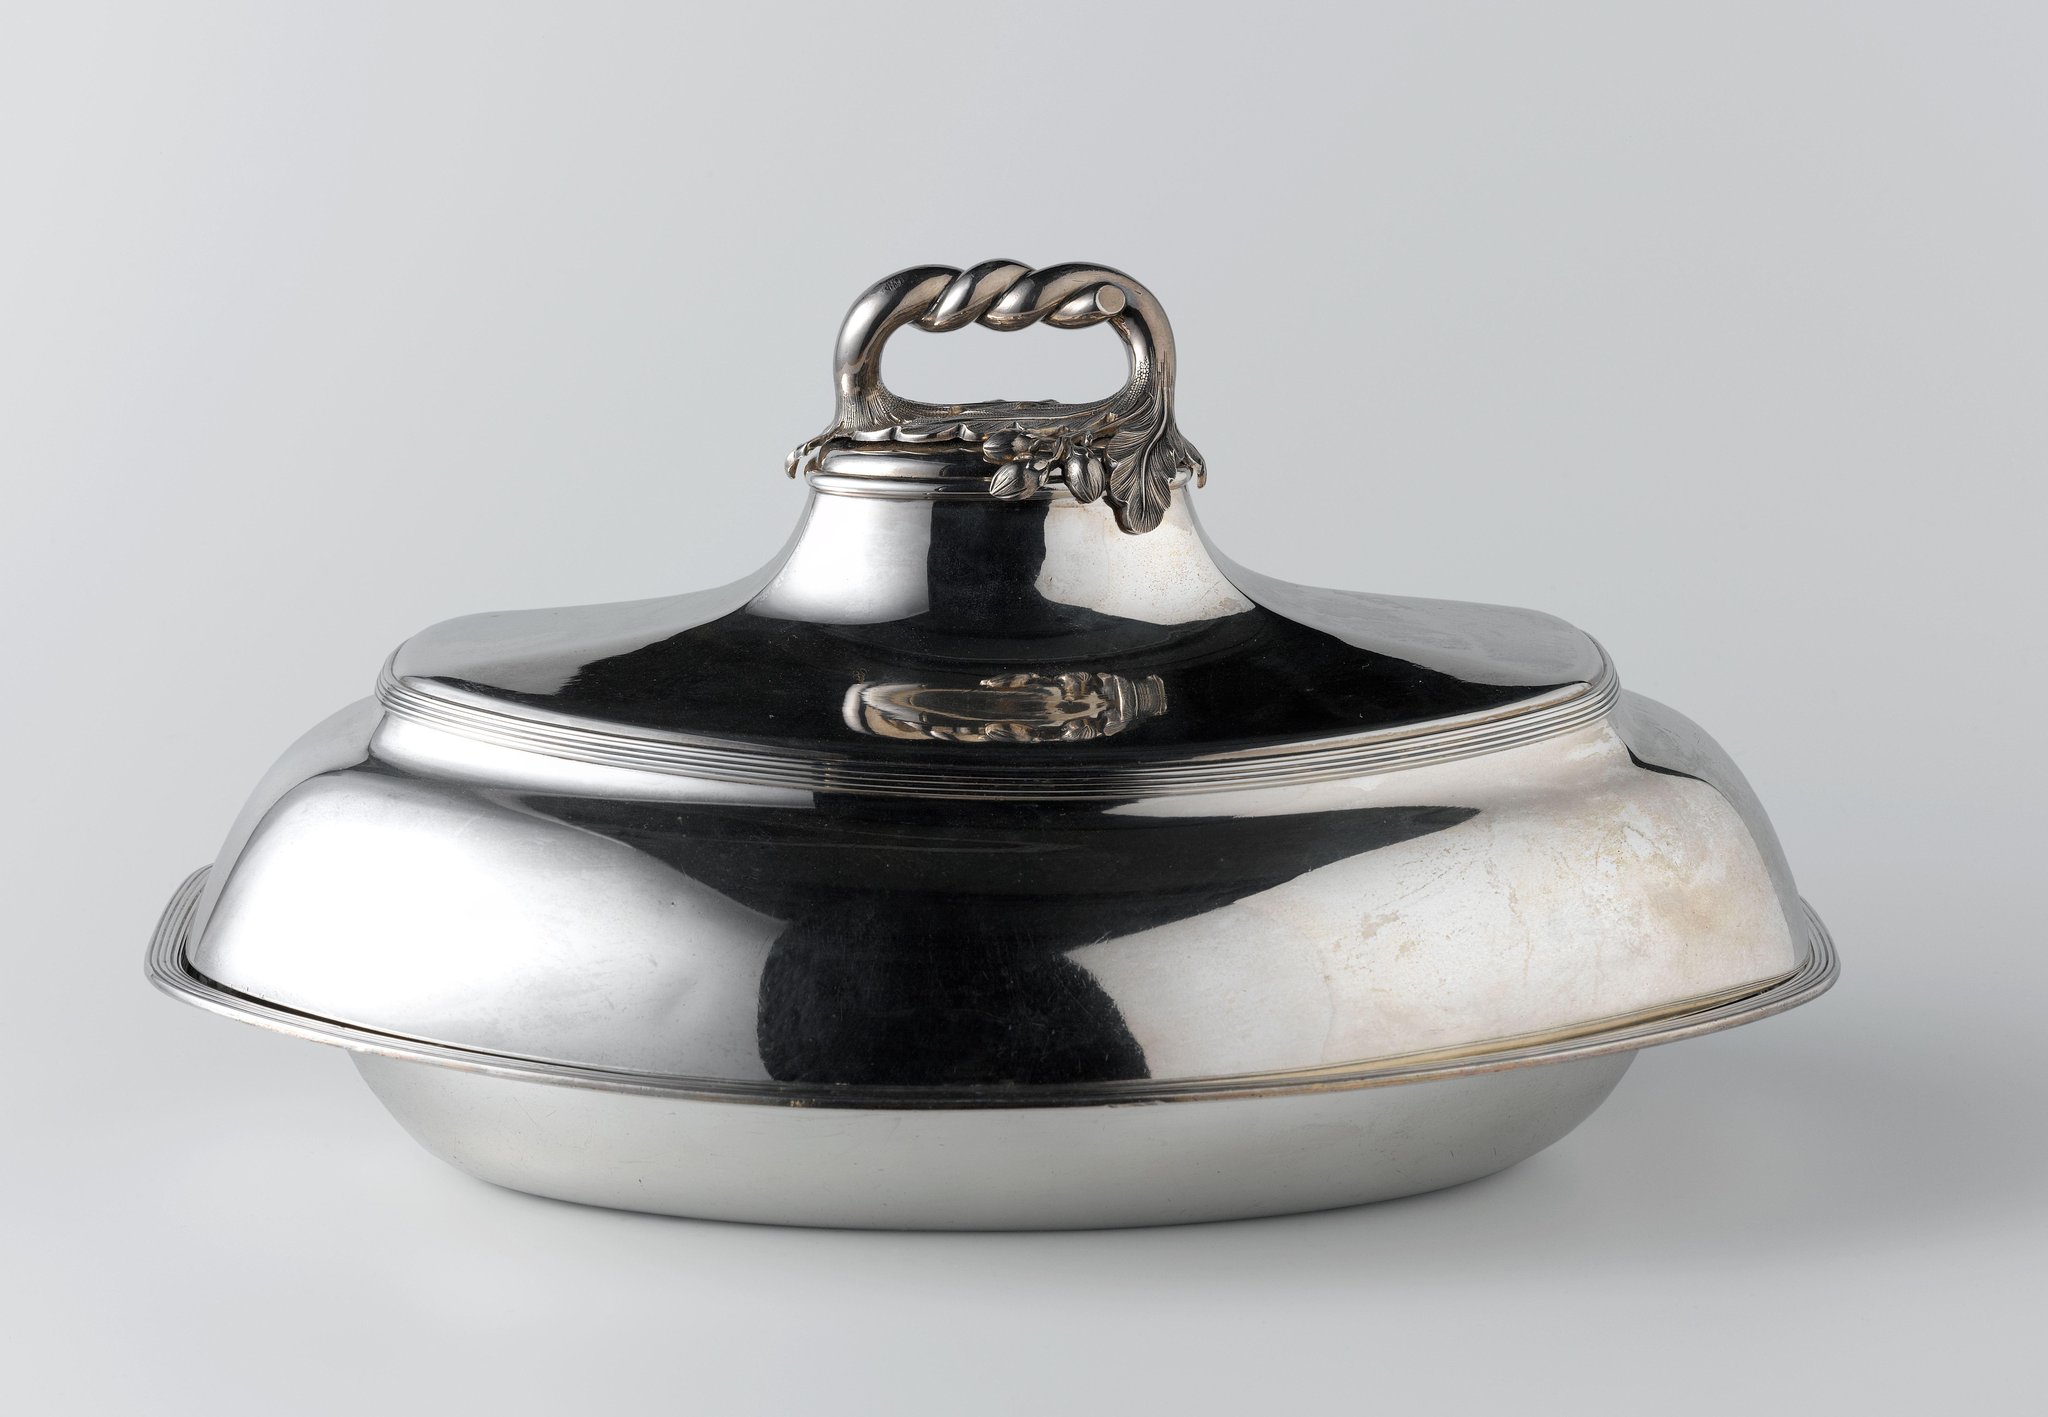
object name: vessel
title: Deksel van dekschaal, behorend bij komfoor, gedecoreerd met filetranden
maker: jacob hendrik stellingwerff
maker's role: silversmith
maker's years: 1773-1823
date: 1816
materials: silver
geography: amsterdam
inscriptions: alloy mark, duty mark: ‘I’, retailer's mark: ‘BENNEWITZ BONEBAKKER’, maker's mark, assay office mark, date letter: ‘G’, assayer's mark: ‘S1 in ovaal’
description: Het deksel bestaan uit een convex onder- en een concaaf bovengedeelte, waartussen de scheiding door een filetrand gemarkeerd wordt. Het deksel is bekroond door een greep in de vorm van twee bladertakjes met eikels, die in het midden om elkaar heen gedraaid zijn.